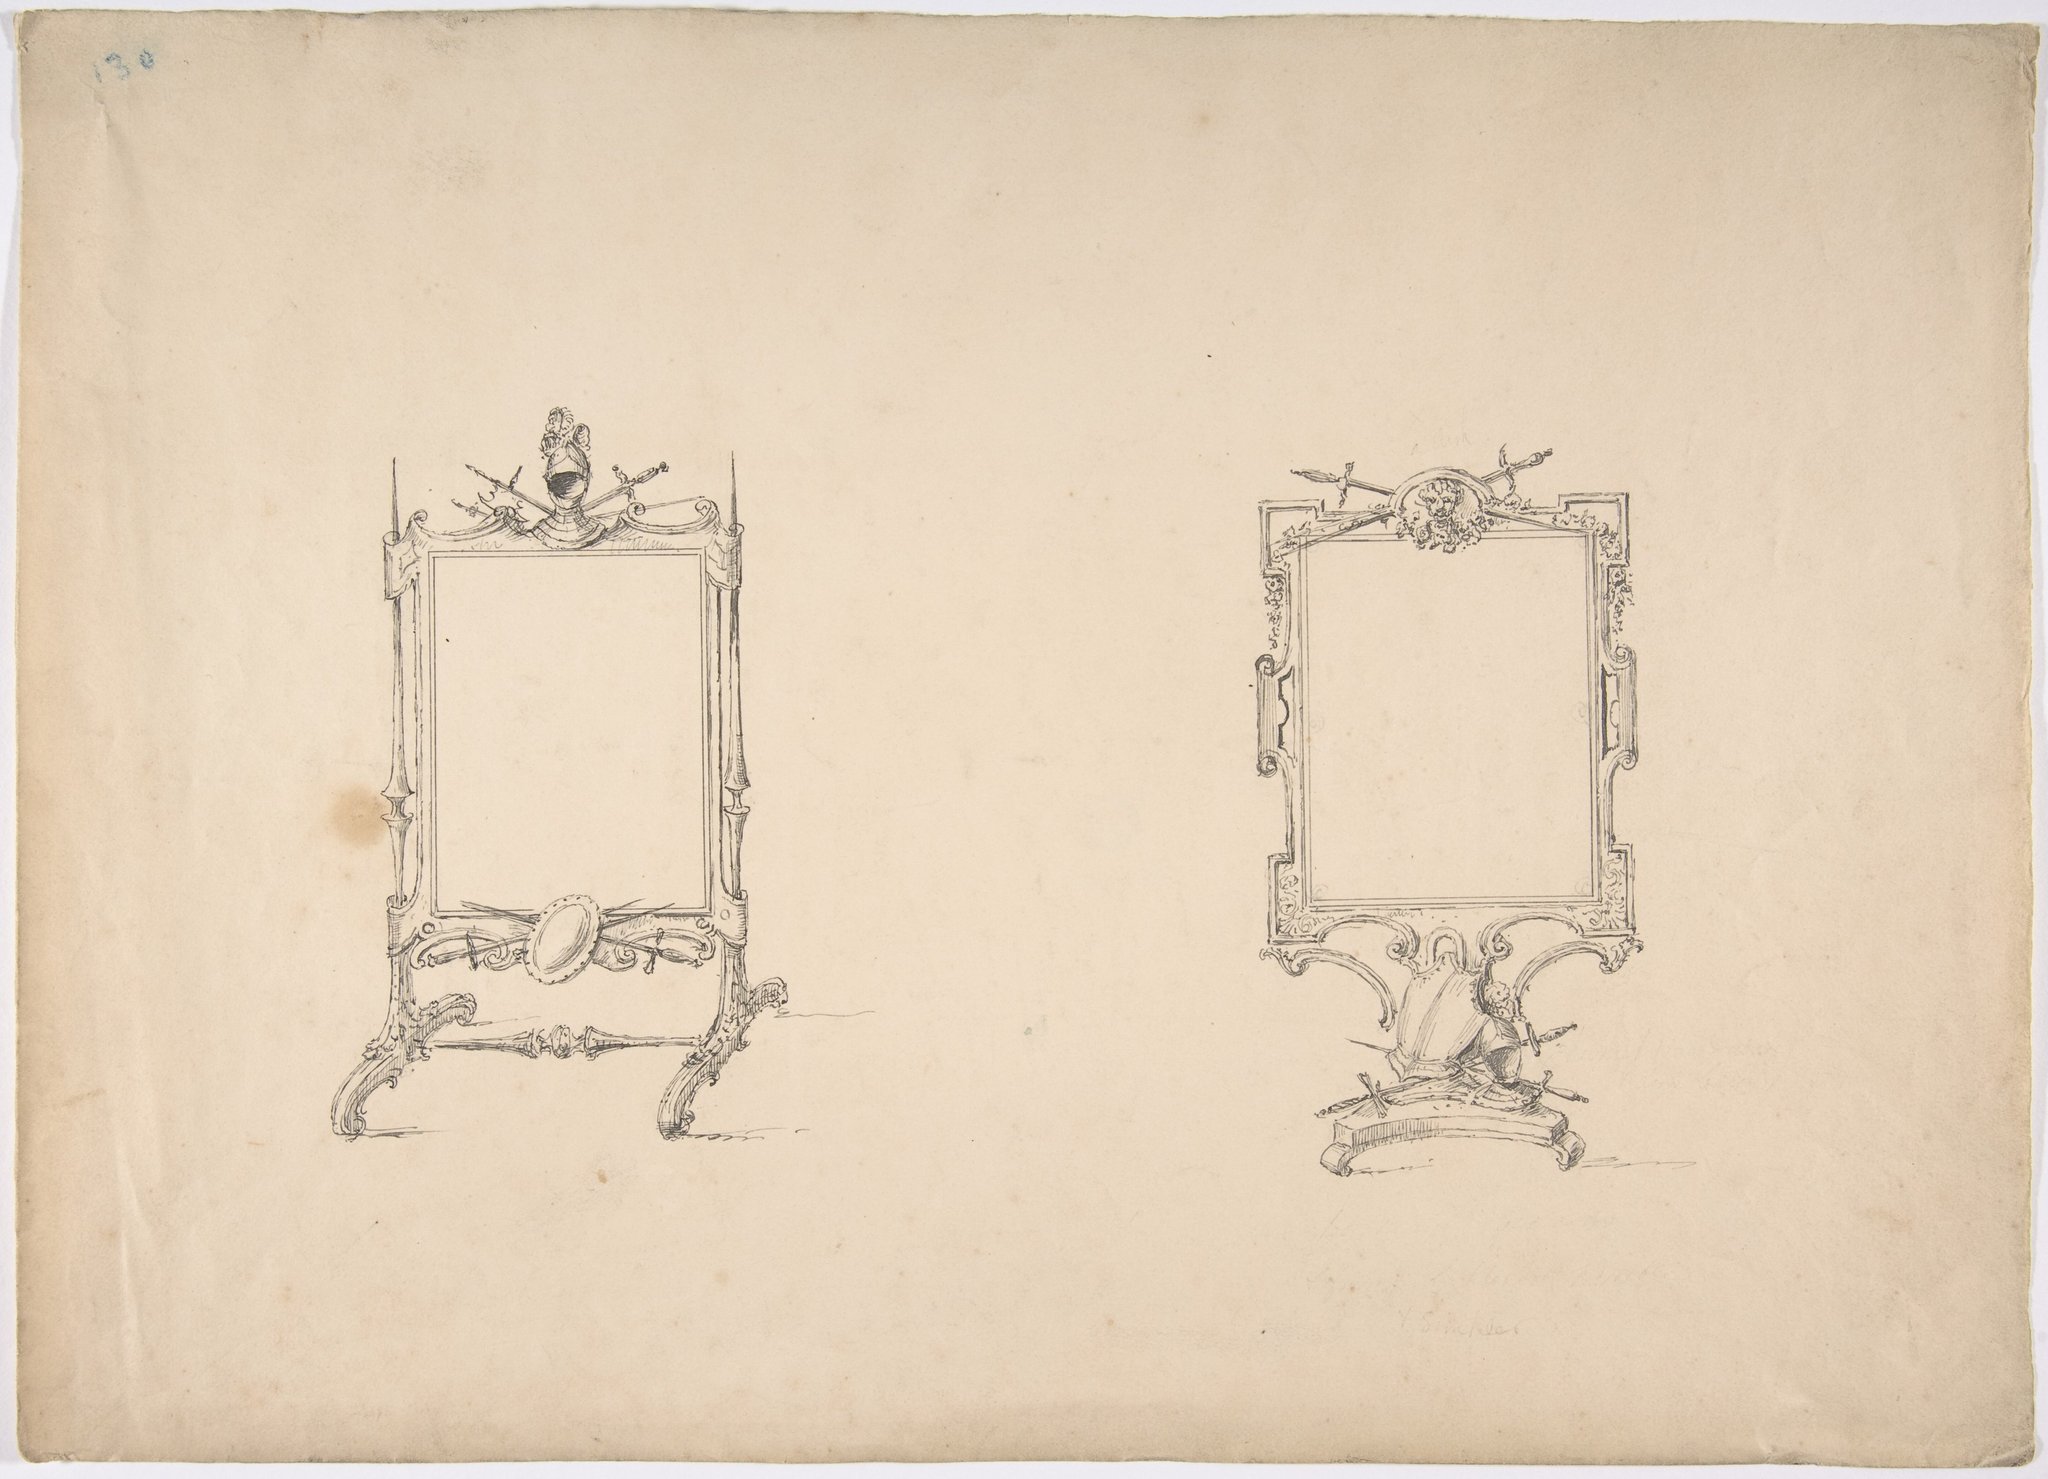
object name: drawing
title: Design for Two Tabletop Mirrors with Military Ornament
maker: anonymous, british, 19th century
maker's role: artist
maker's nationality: british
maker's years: 1800-1900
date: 1801-1833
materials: ink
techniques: pen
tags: military equipment,mirrors